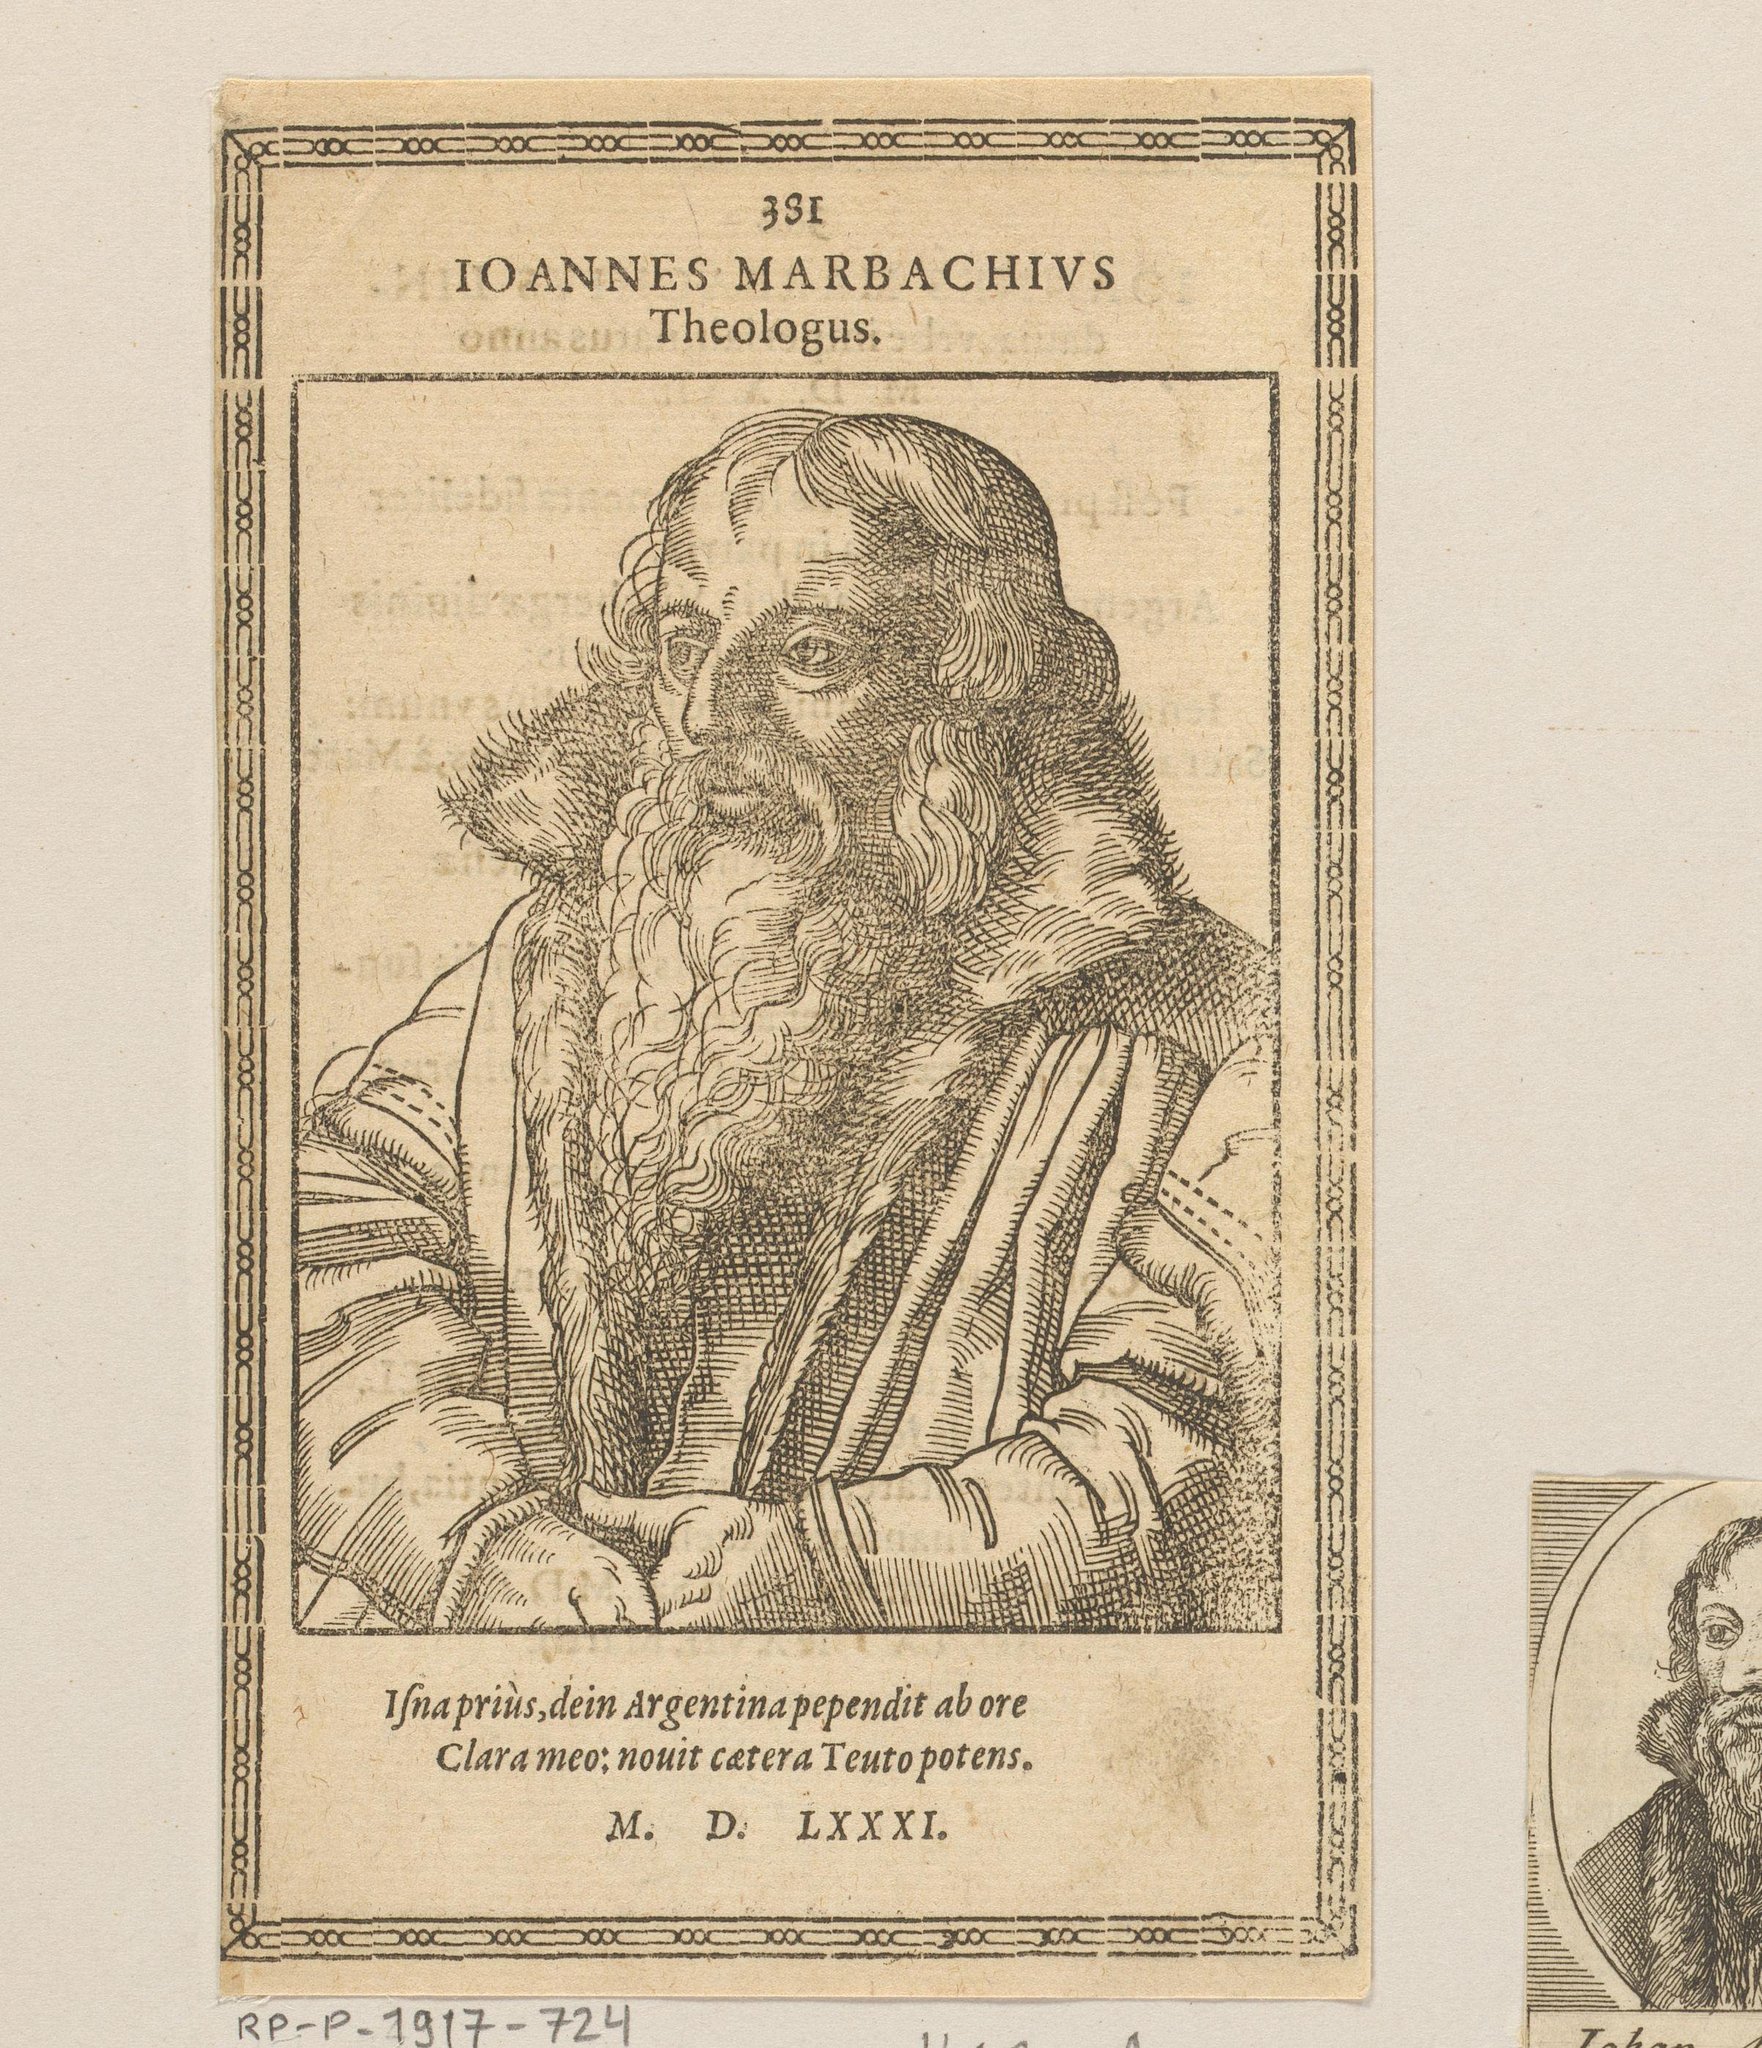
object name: print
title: Portret van Johann Marbach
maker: bernhard jobin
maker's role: printer, publisher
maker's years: 1545-1593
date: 1590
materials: paper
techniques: letterpress printing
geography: straatsburg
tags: theologian, historical persons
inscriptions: collector's mark: Lugt 2228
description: Prent uit: Reusner, Nikolaus. Icones sive imagines virorum literis illustrium (...). Straatsburg: Bernhard Jobin, 1590, p. 381. Prent voor het eerst verschenen in de eerste editie van 1587. Prent ook gebruikt in latere publicaties.